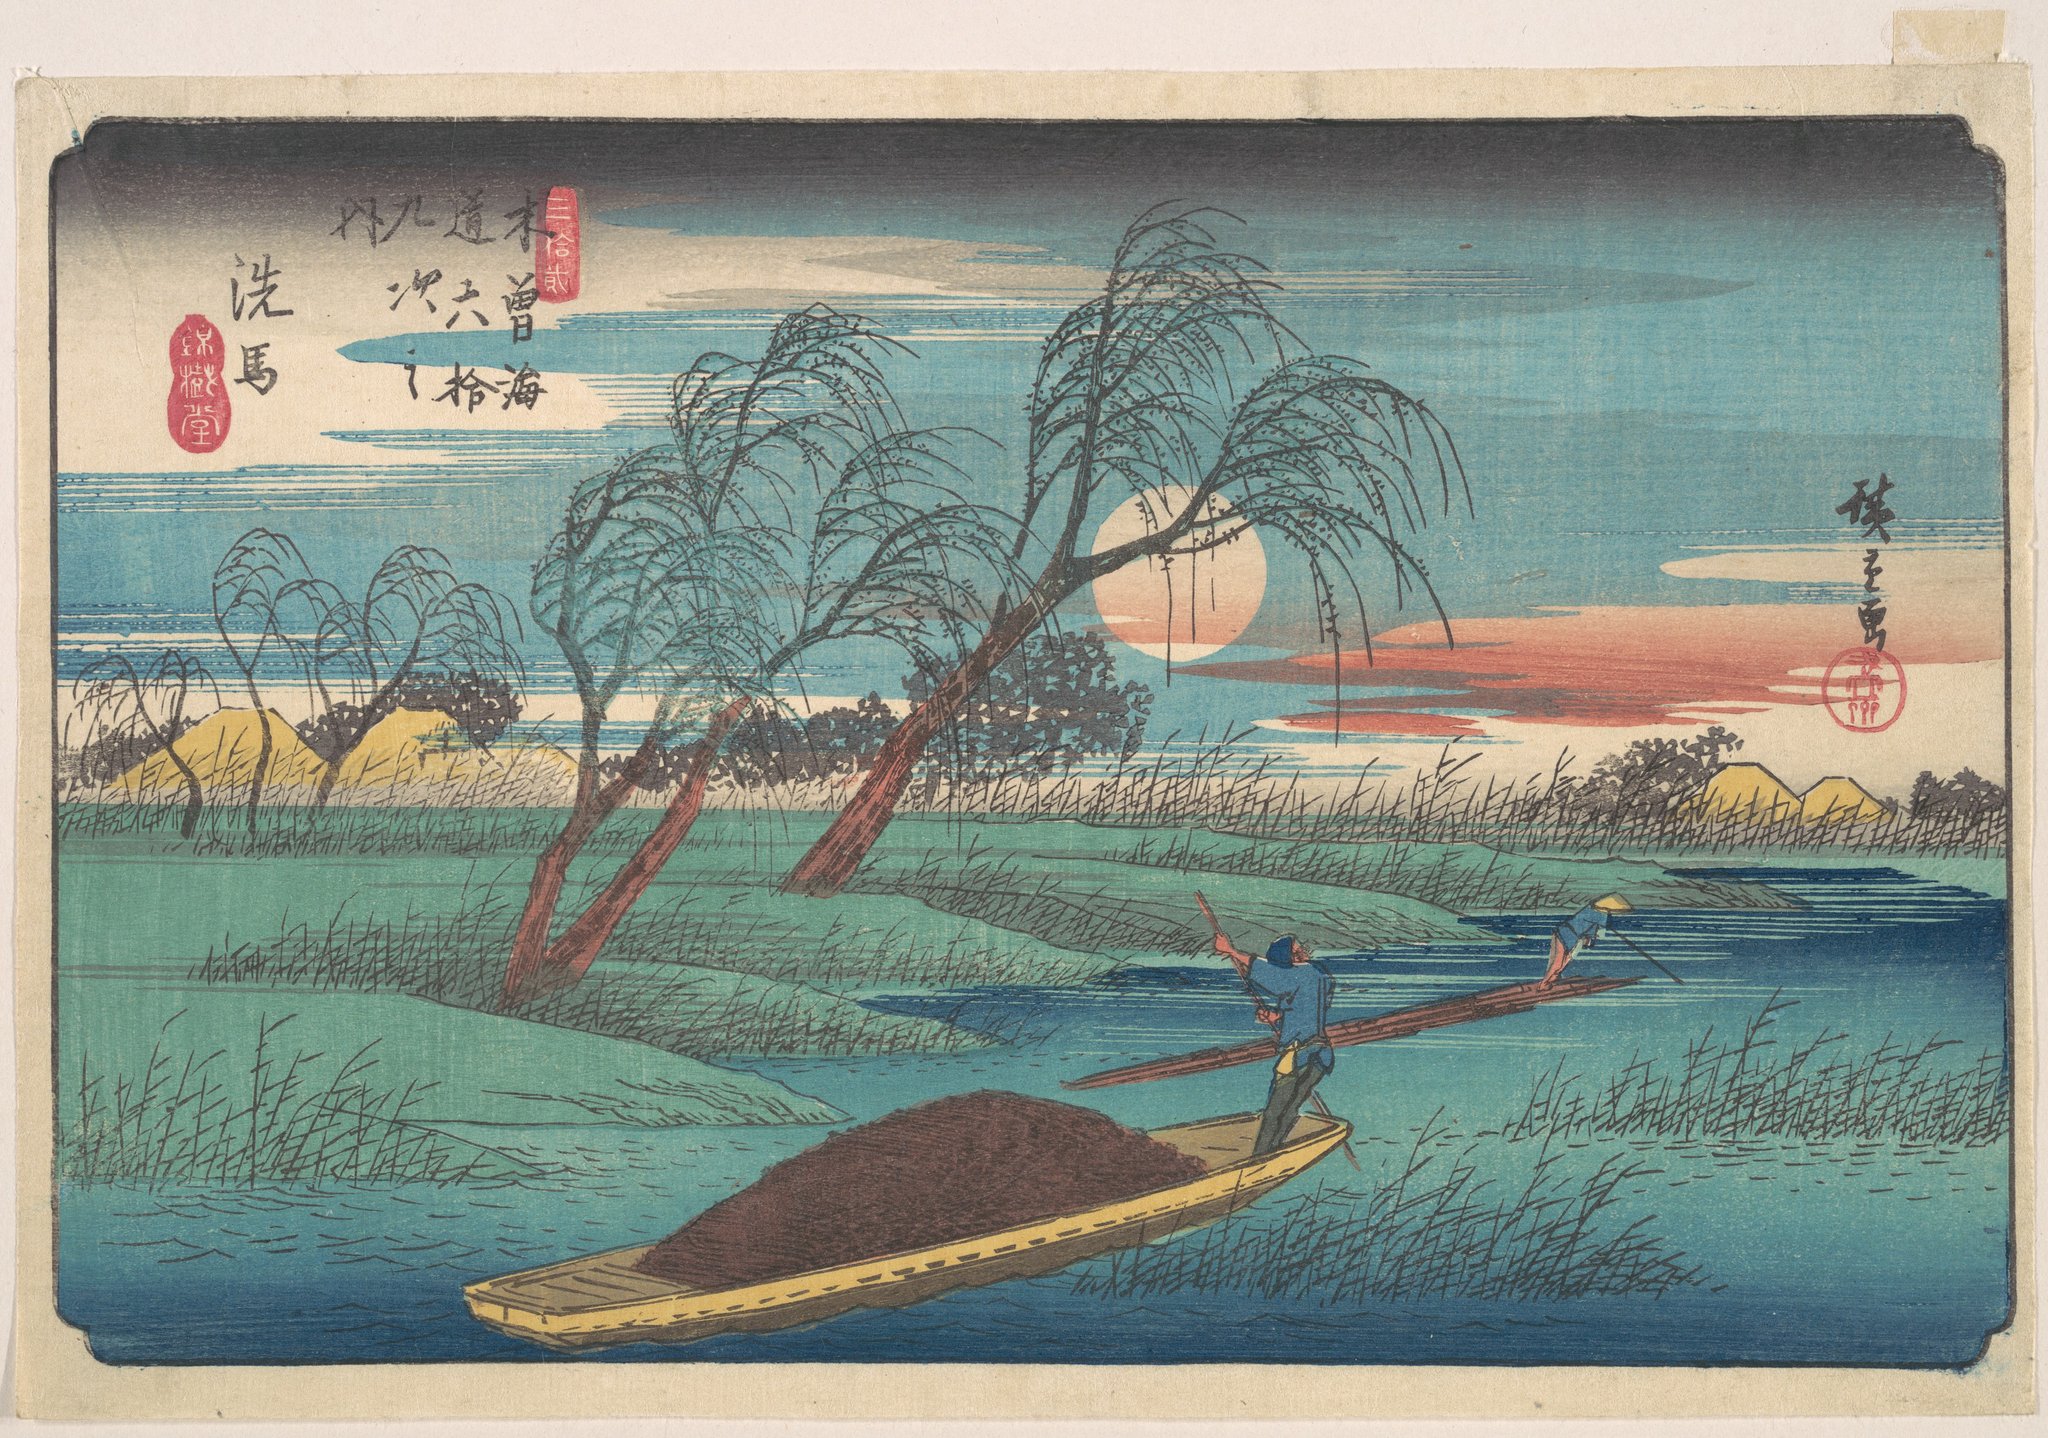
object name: print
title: Senba Station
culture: japanese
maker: utagawa hiroshige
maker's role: artist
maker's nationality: japanese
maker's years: 1797-1858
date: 1835-1848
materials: ink, paper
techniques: woodblock print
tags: trees,boats,streams